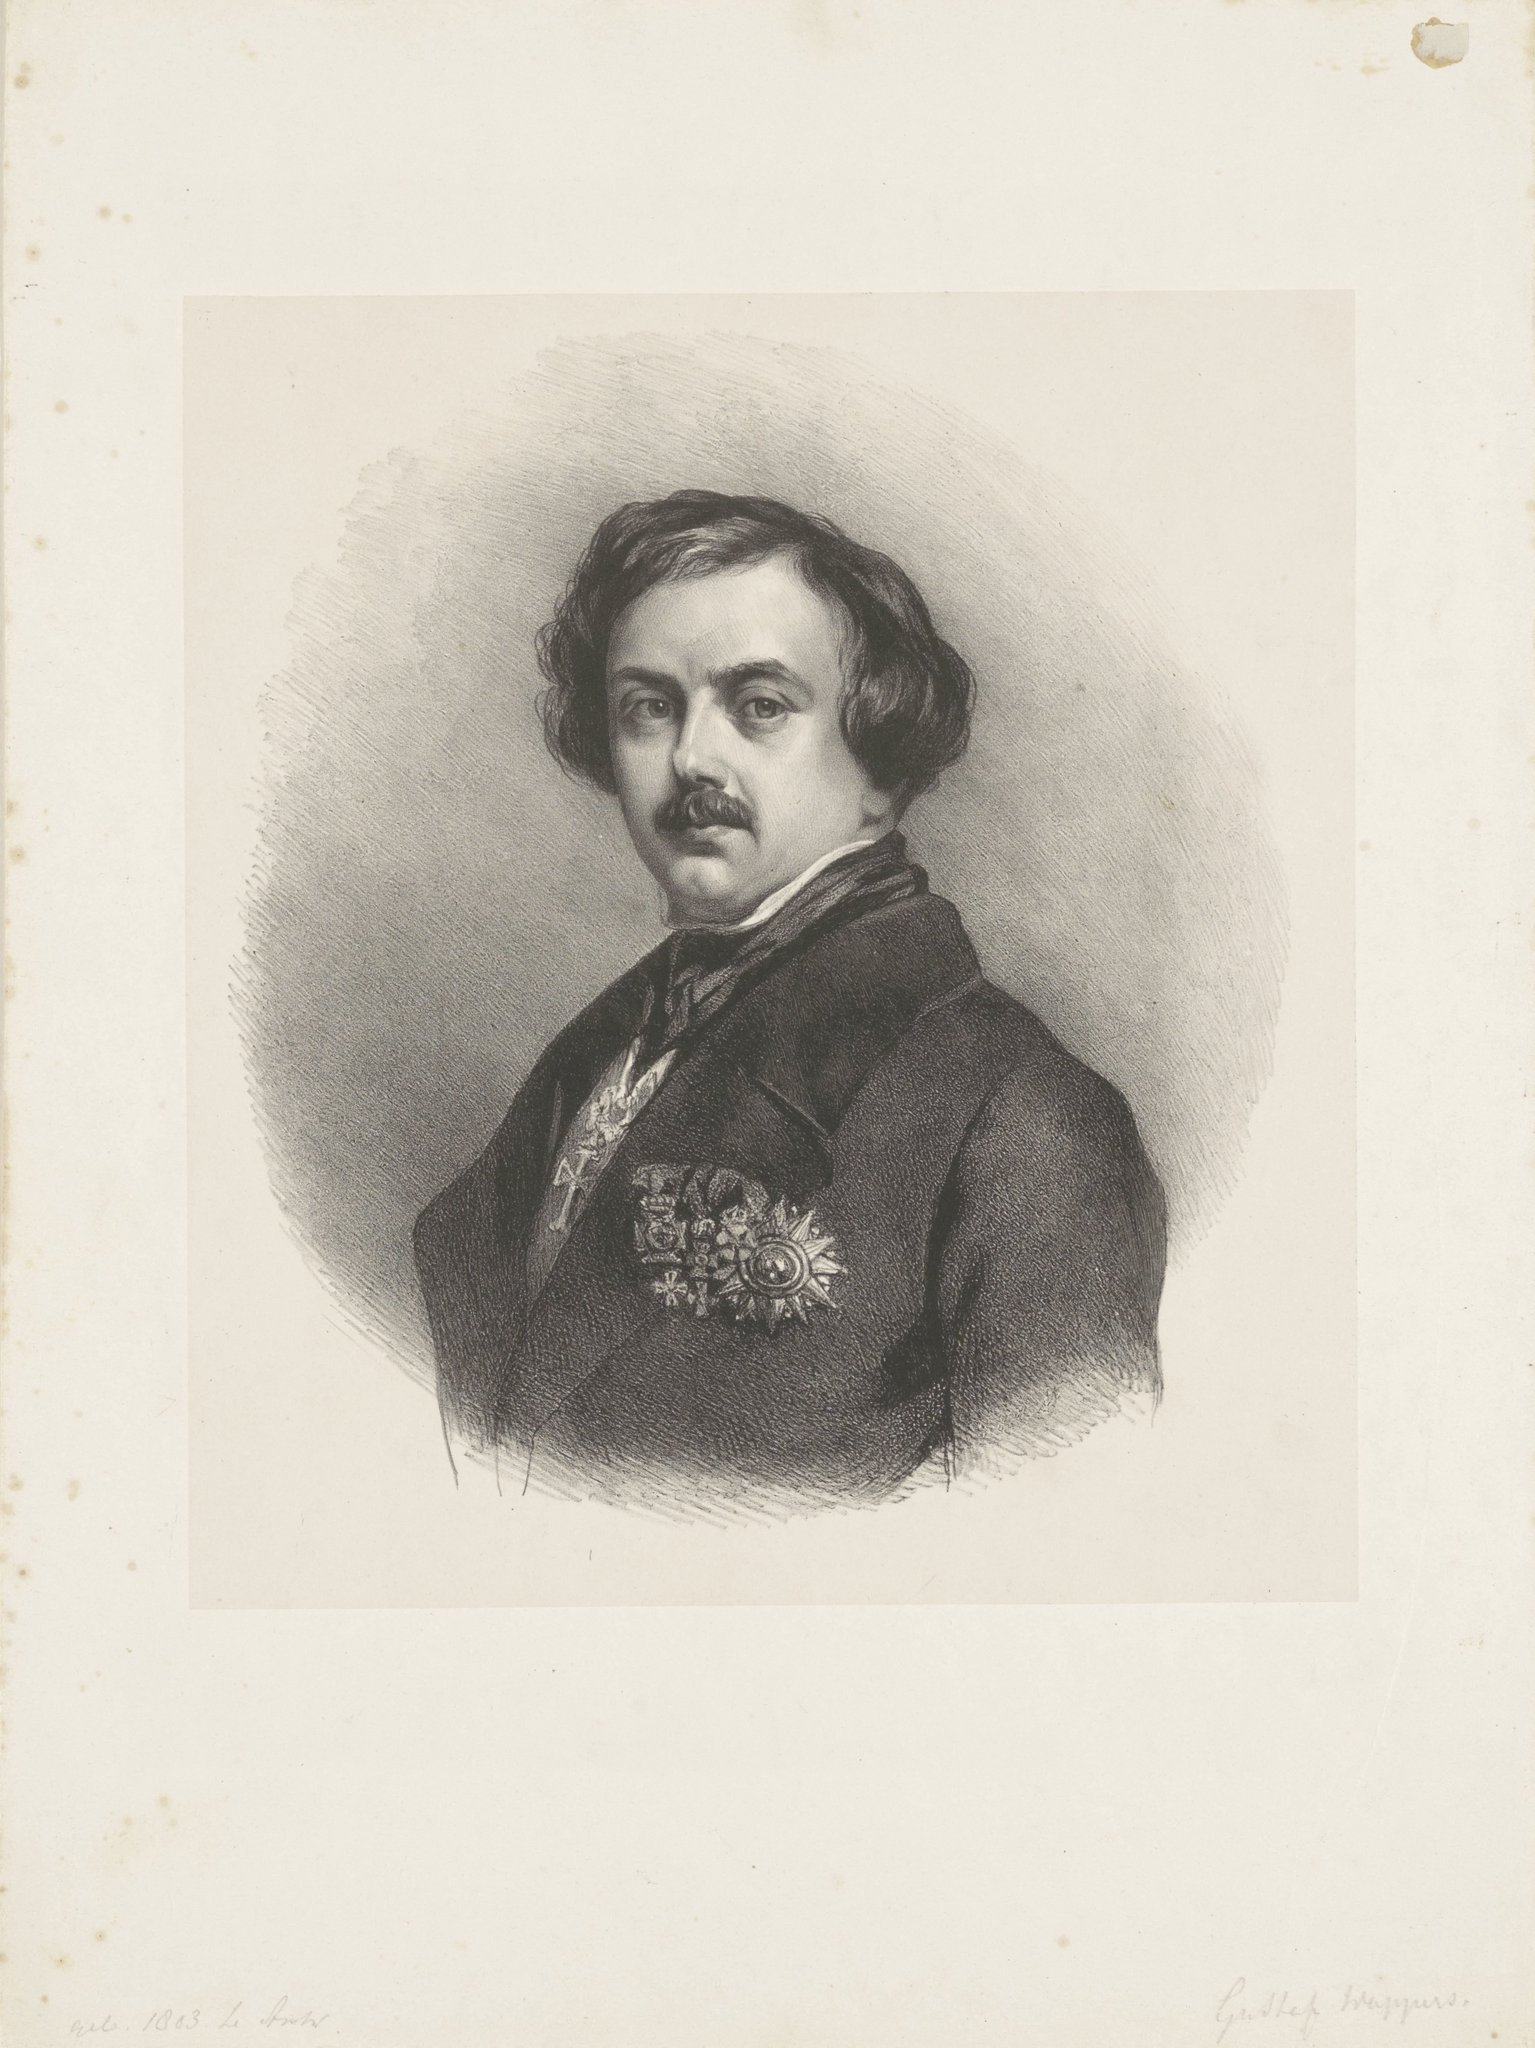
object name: print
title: Portret van Gustave Wappers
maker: adrianus johannes ehnle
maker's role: draughtsman, print maker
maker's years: 1819-1863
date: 1829-1853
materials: paper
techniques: lithograph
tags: antwerp, paris, painter, print maker, draughtsman, gustave wappers, historical persons (+ (full) bust portrait)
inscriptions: collector's mark: Lugt 2228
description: De geportretteerde draagt een aantal ridderorden op zijn borst en om zijn hals.